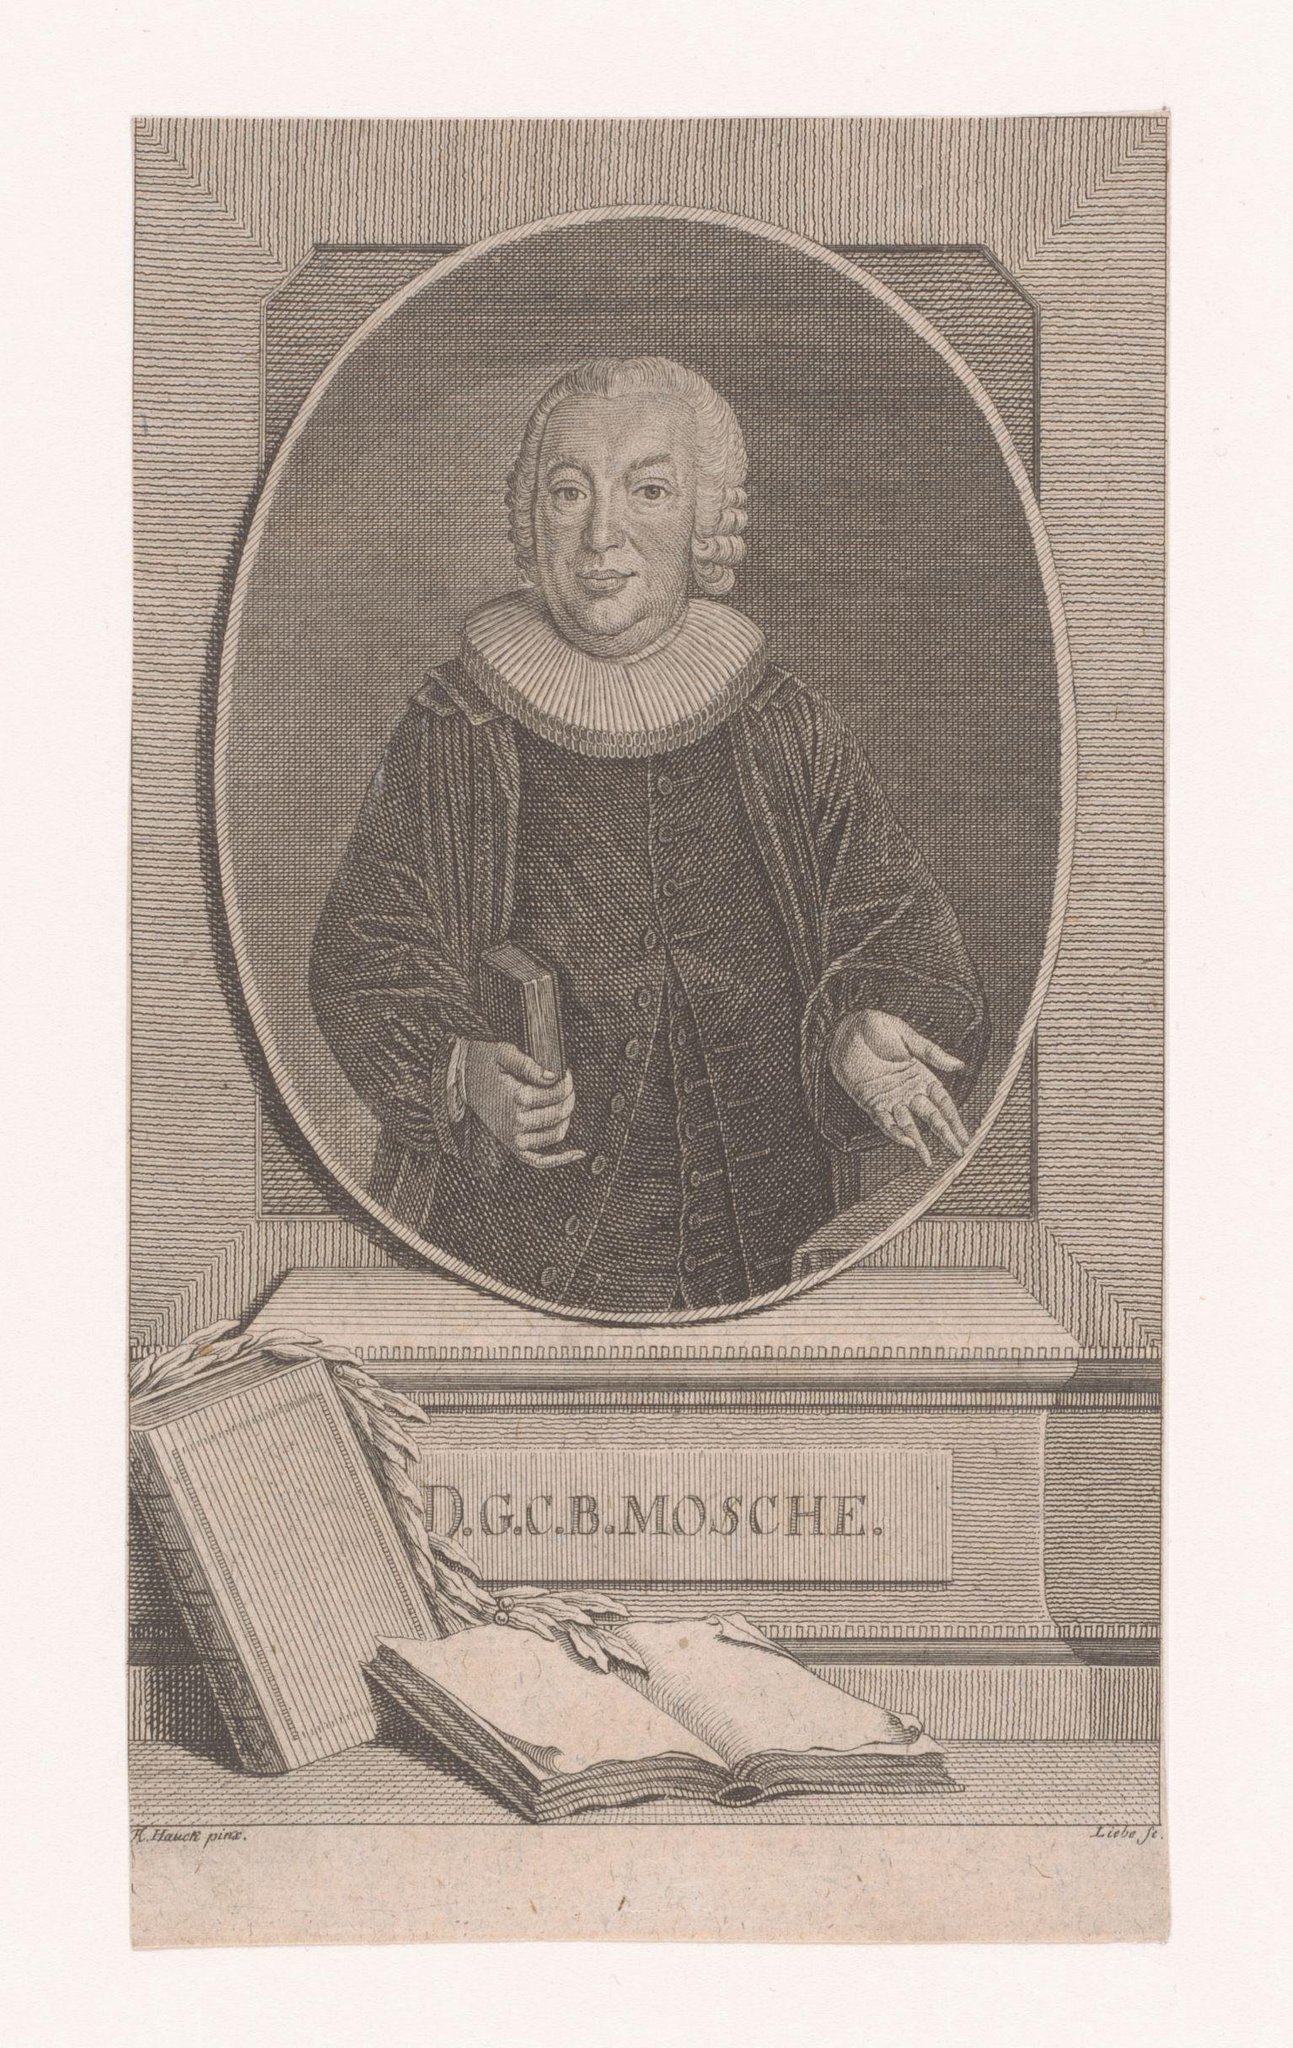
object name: print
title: Portret van Gabriel Christoph Benjamin Mosche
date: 1756-1819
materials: paper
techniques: engraving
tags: theologian, historical persons, book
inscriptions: collector's mark: Lugt 2228